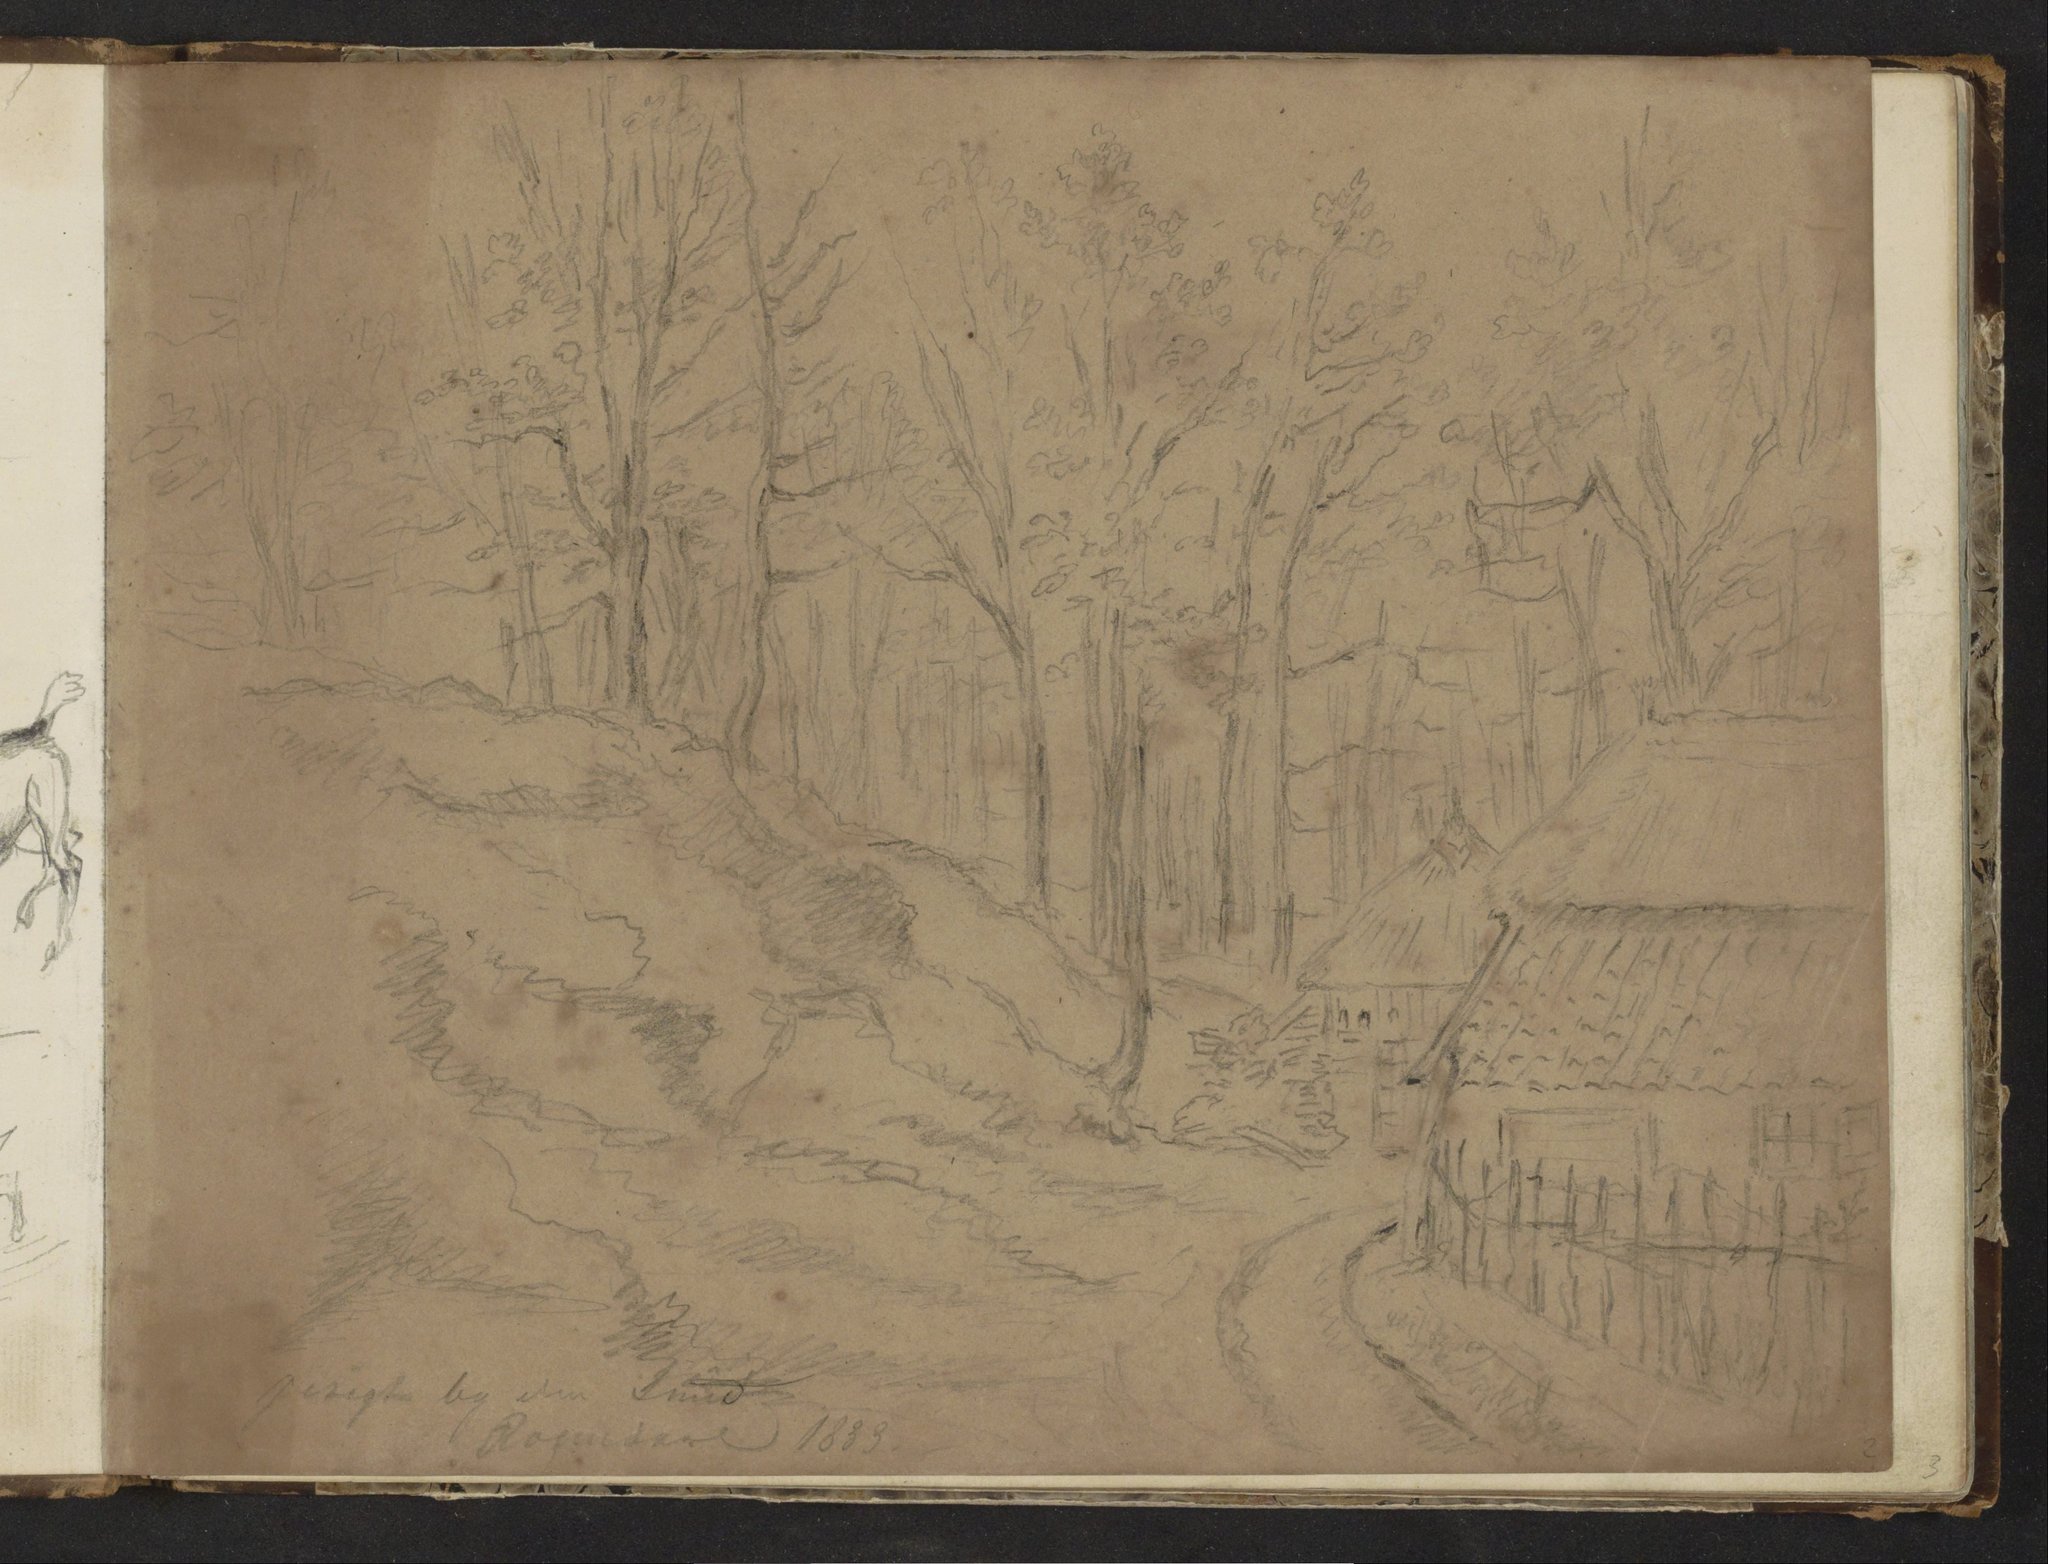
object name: sketchbook leaf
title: Huis van een smid in het bos van Rozendaal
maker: johannes tavenraat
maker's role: draughtsman, painter, print maker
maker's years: 1809-1881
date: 1833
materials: paper, pencil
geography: rozendaal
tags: forest, wood, cottage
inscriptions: date and inscription: ‘gezigt bij den Smid/ Rosendaal 1833.’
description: Blad 2 recto uit een schetsboek met 41 bladen.